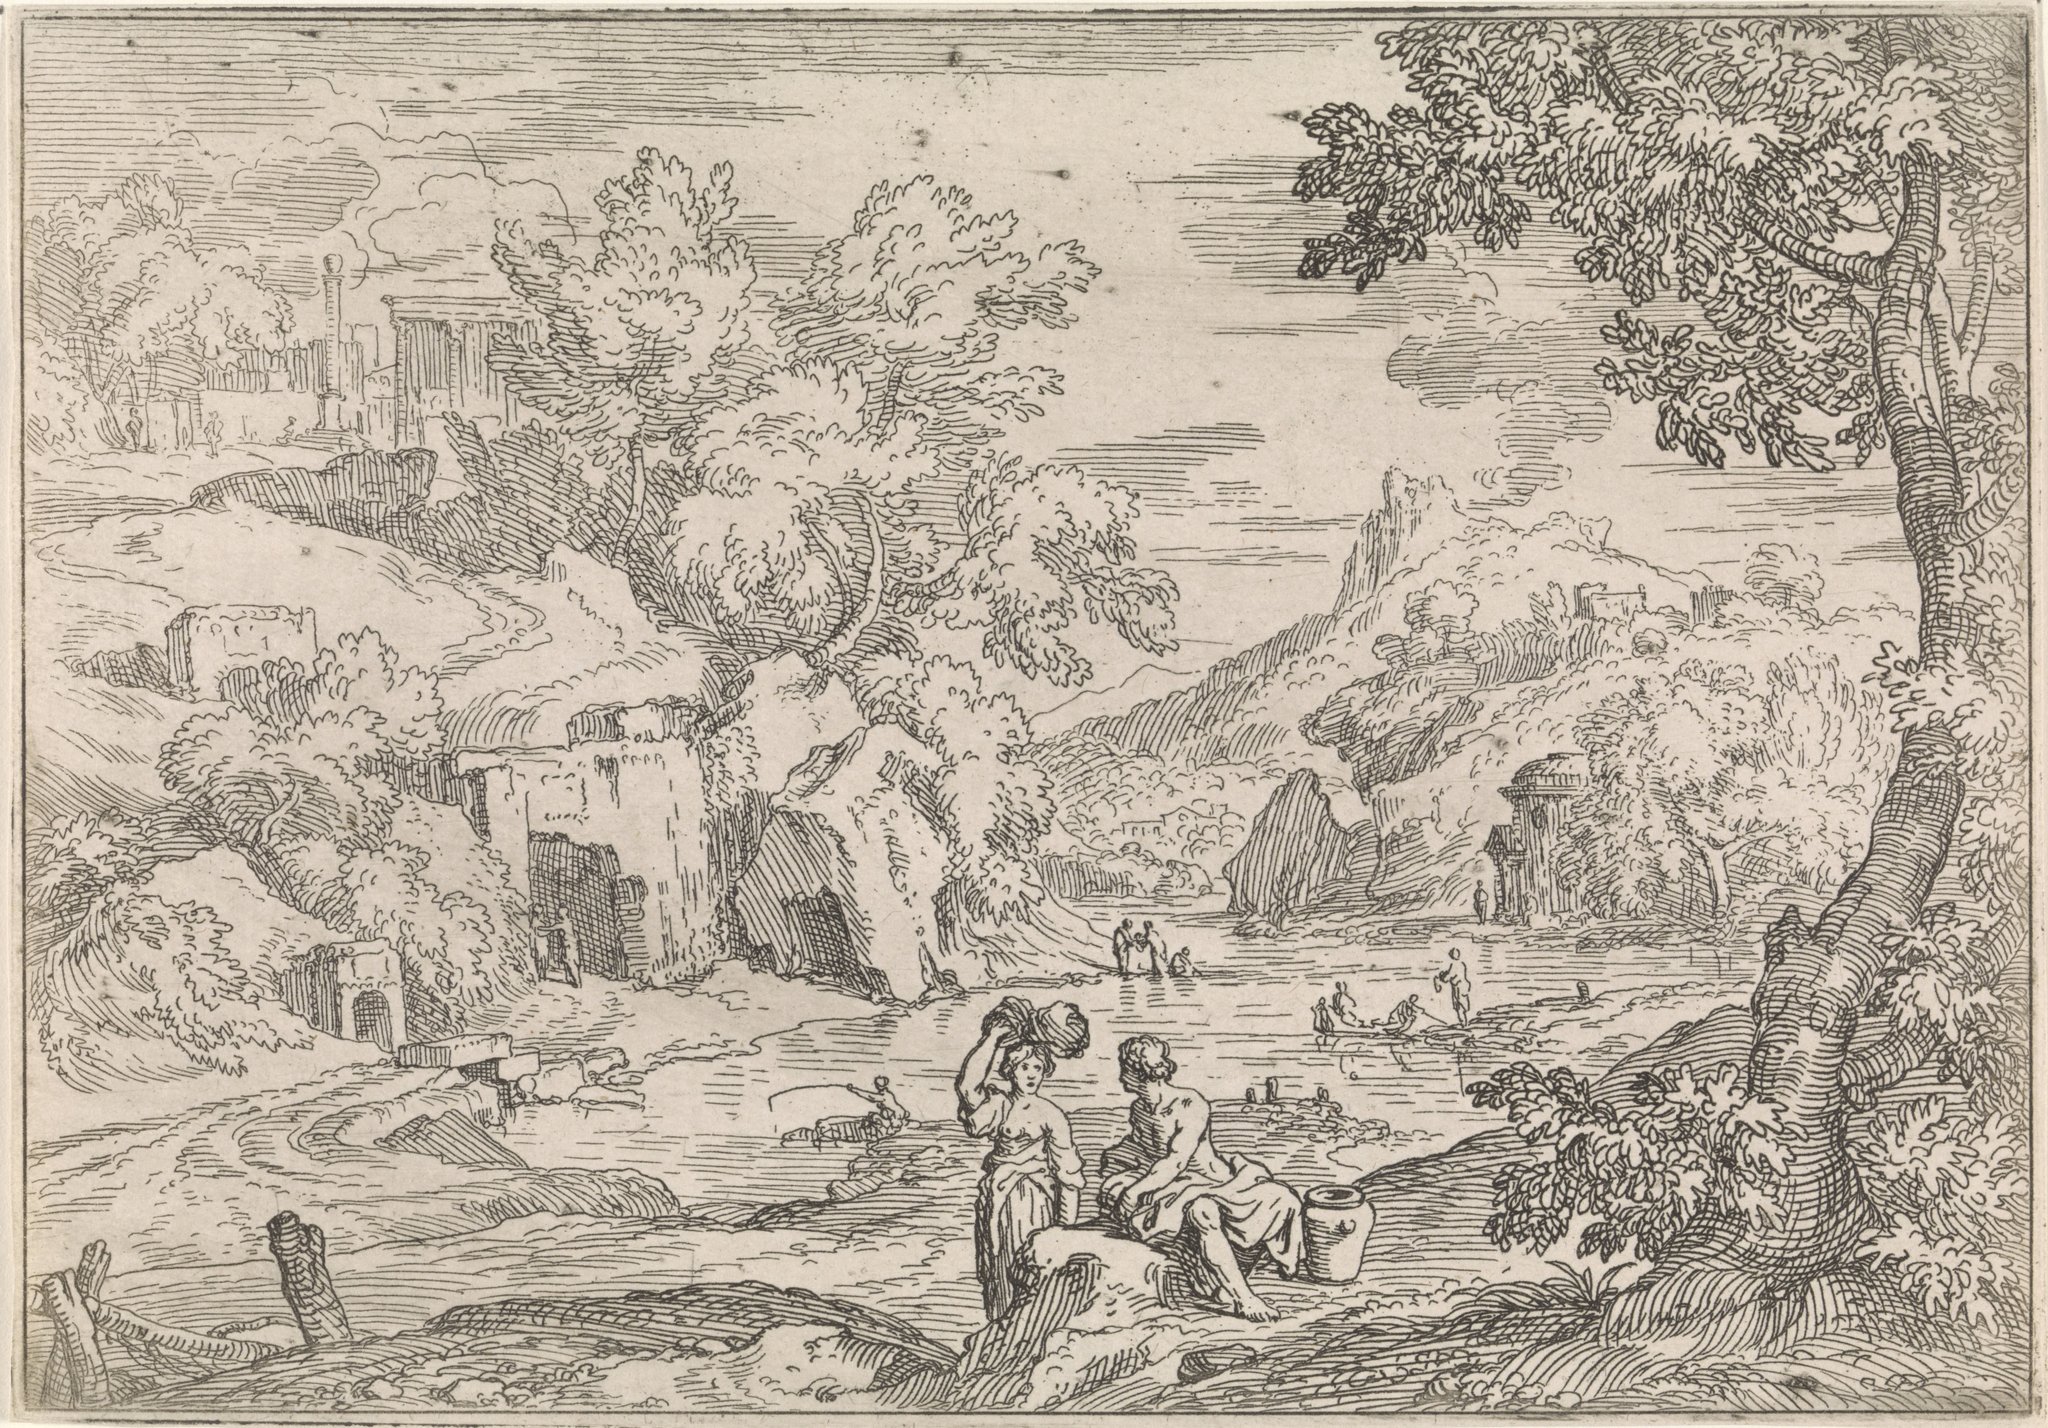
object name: print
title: Arcadische landschappen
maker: abraham genoels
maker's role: draughtsman, print maker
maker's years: 1640-1723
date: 1650-1723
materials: paper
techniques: etching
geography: antwerp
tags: temple, shrine ~ roman religion, pastorals, arcadian scenes, lake (+ landscape with figures, staffage)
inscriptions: collector's mark: Lugt 240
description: Een arcadisch landschap met een meer. Aan het meer wassen enkele vrouwen hun kleren. Op de achtergrond een heuvel met een tempel. De prent is deel van een serie van zes Arcadische landschappen.